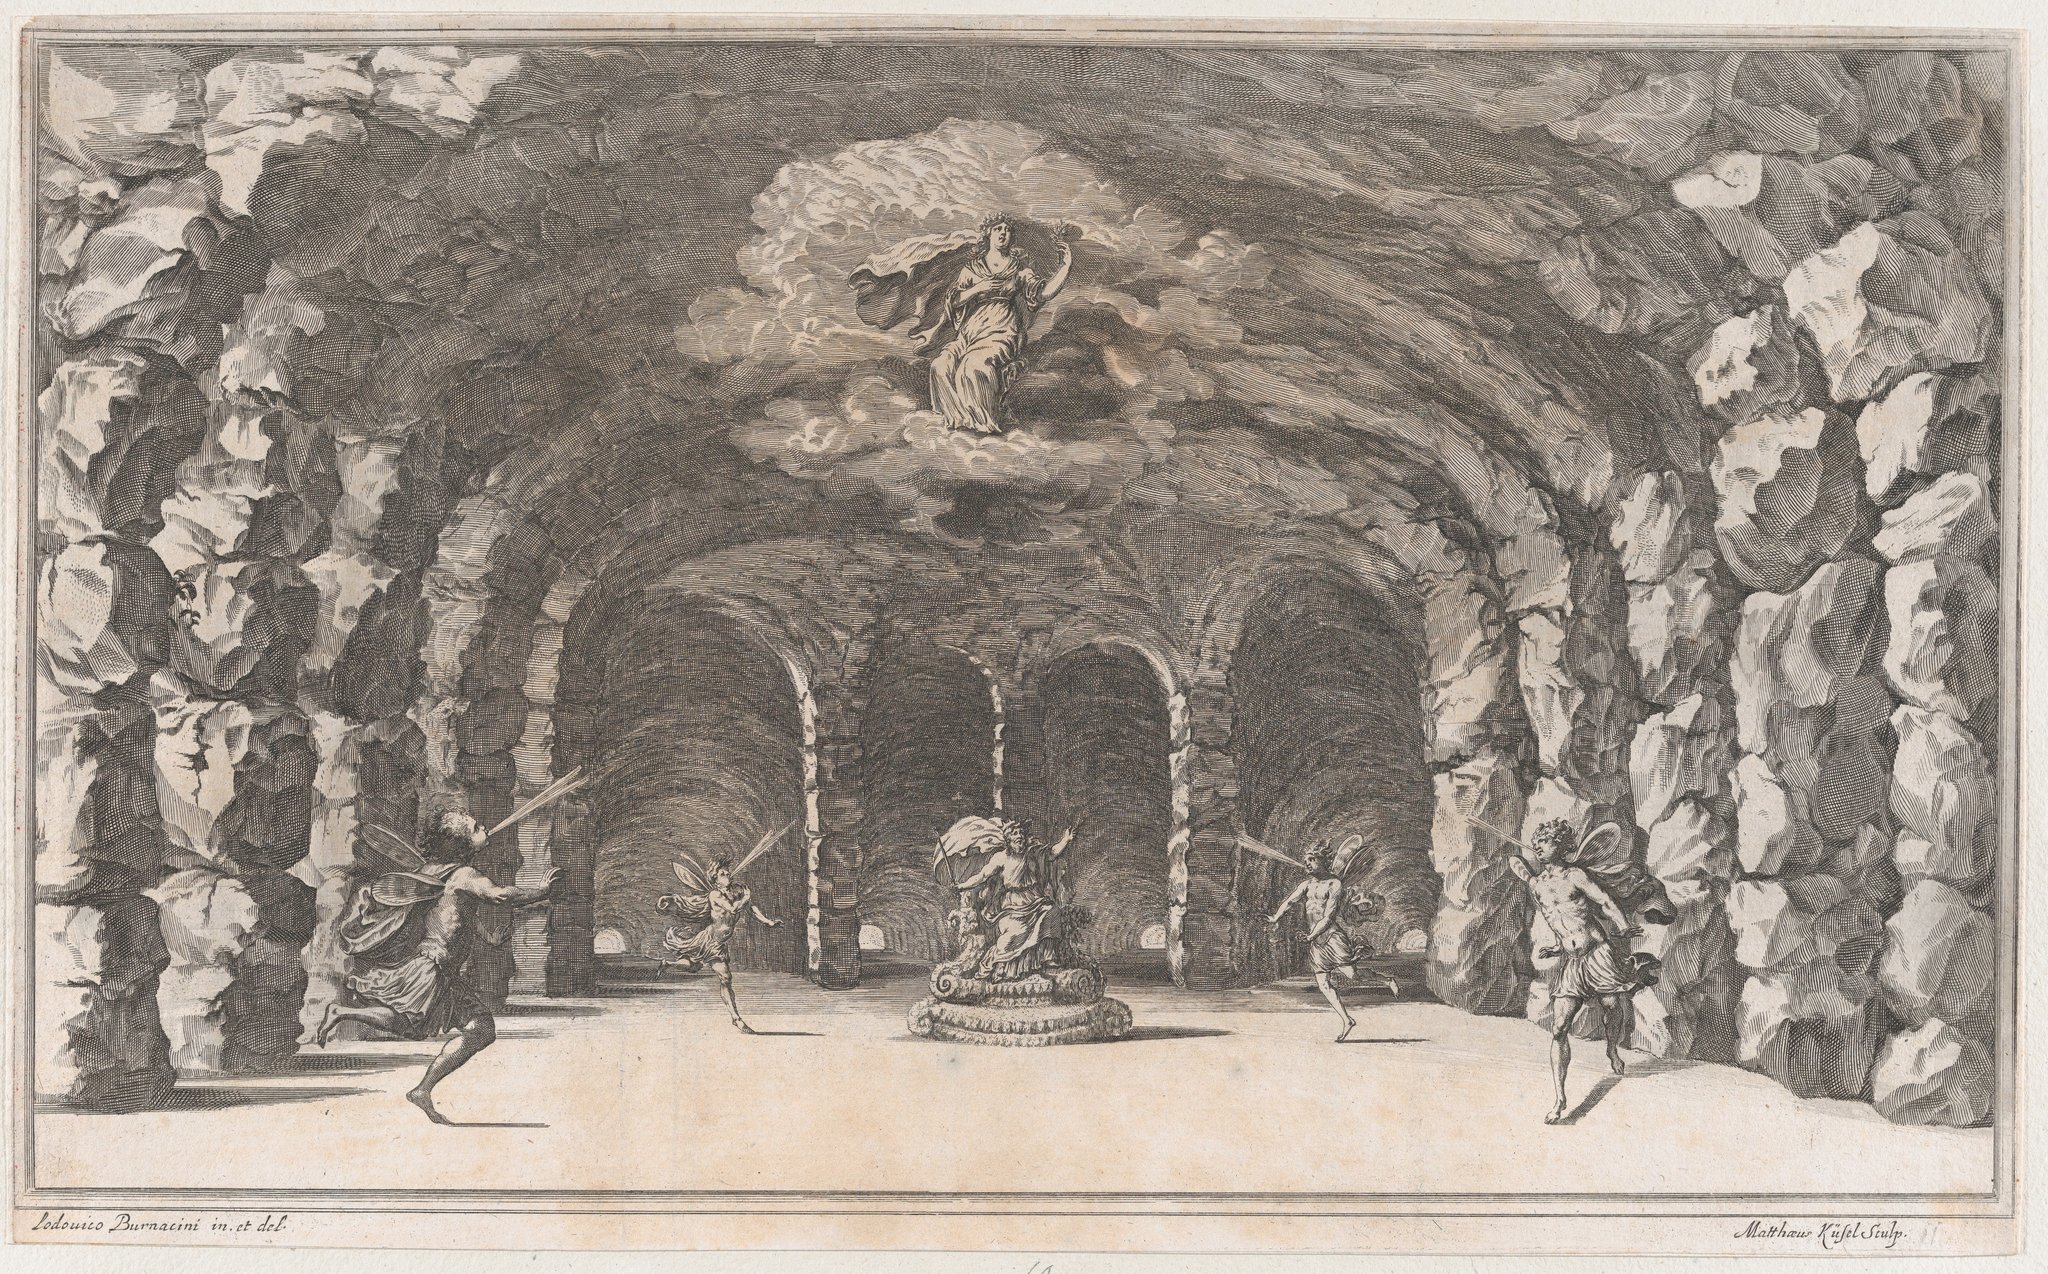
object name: print, fete, ornament architecture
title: Cavern of Aeolus; a cave with wind gods blowing on either side of Aeolus who sits enthroned at center; set design from 'Il Pomo D'Oro'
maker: mathäus küsel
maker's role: artist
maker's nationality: german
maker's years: 1621-1682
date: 1668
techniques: etching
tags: opera,caves,wind